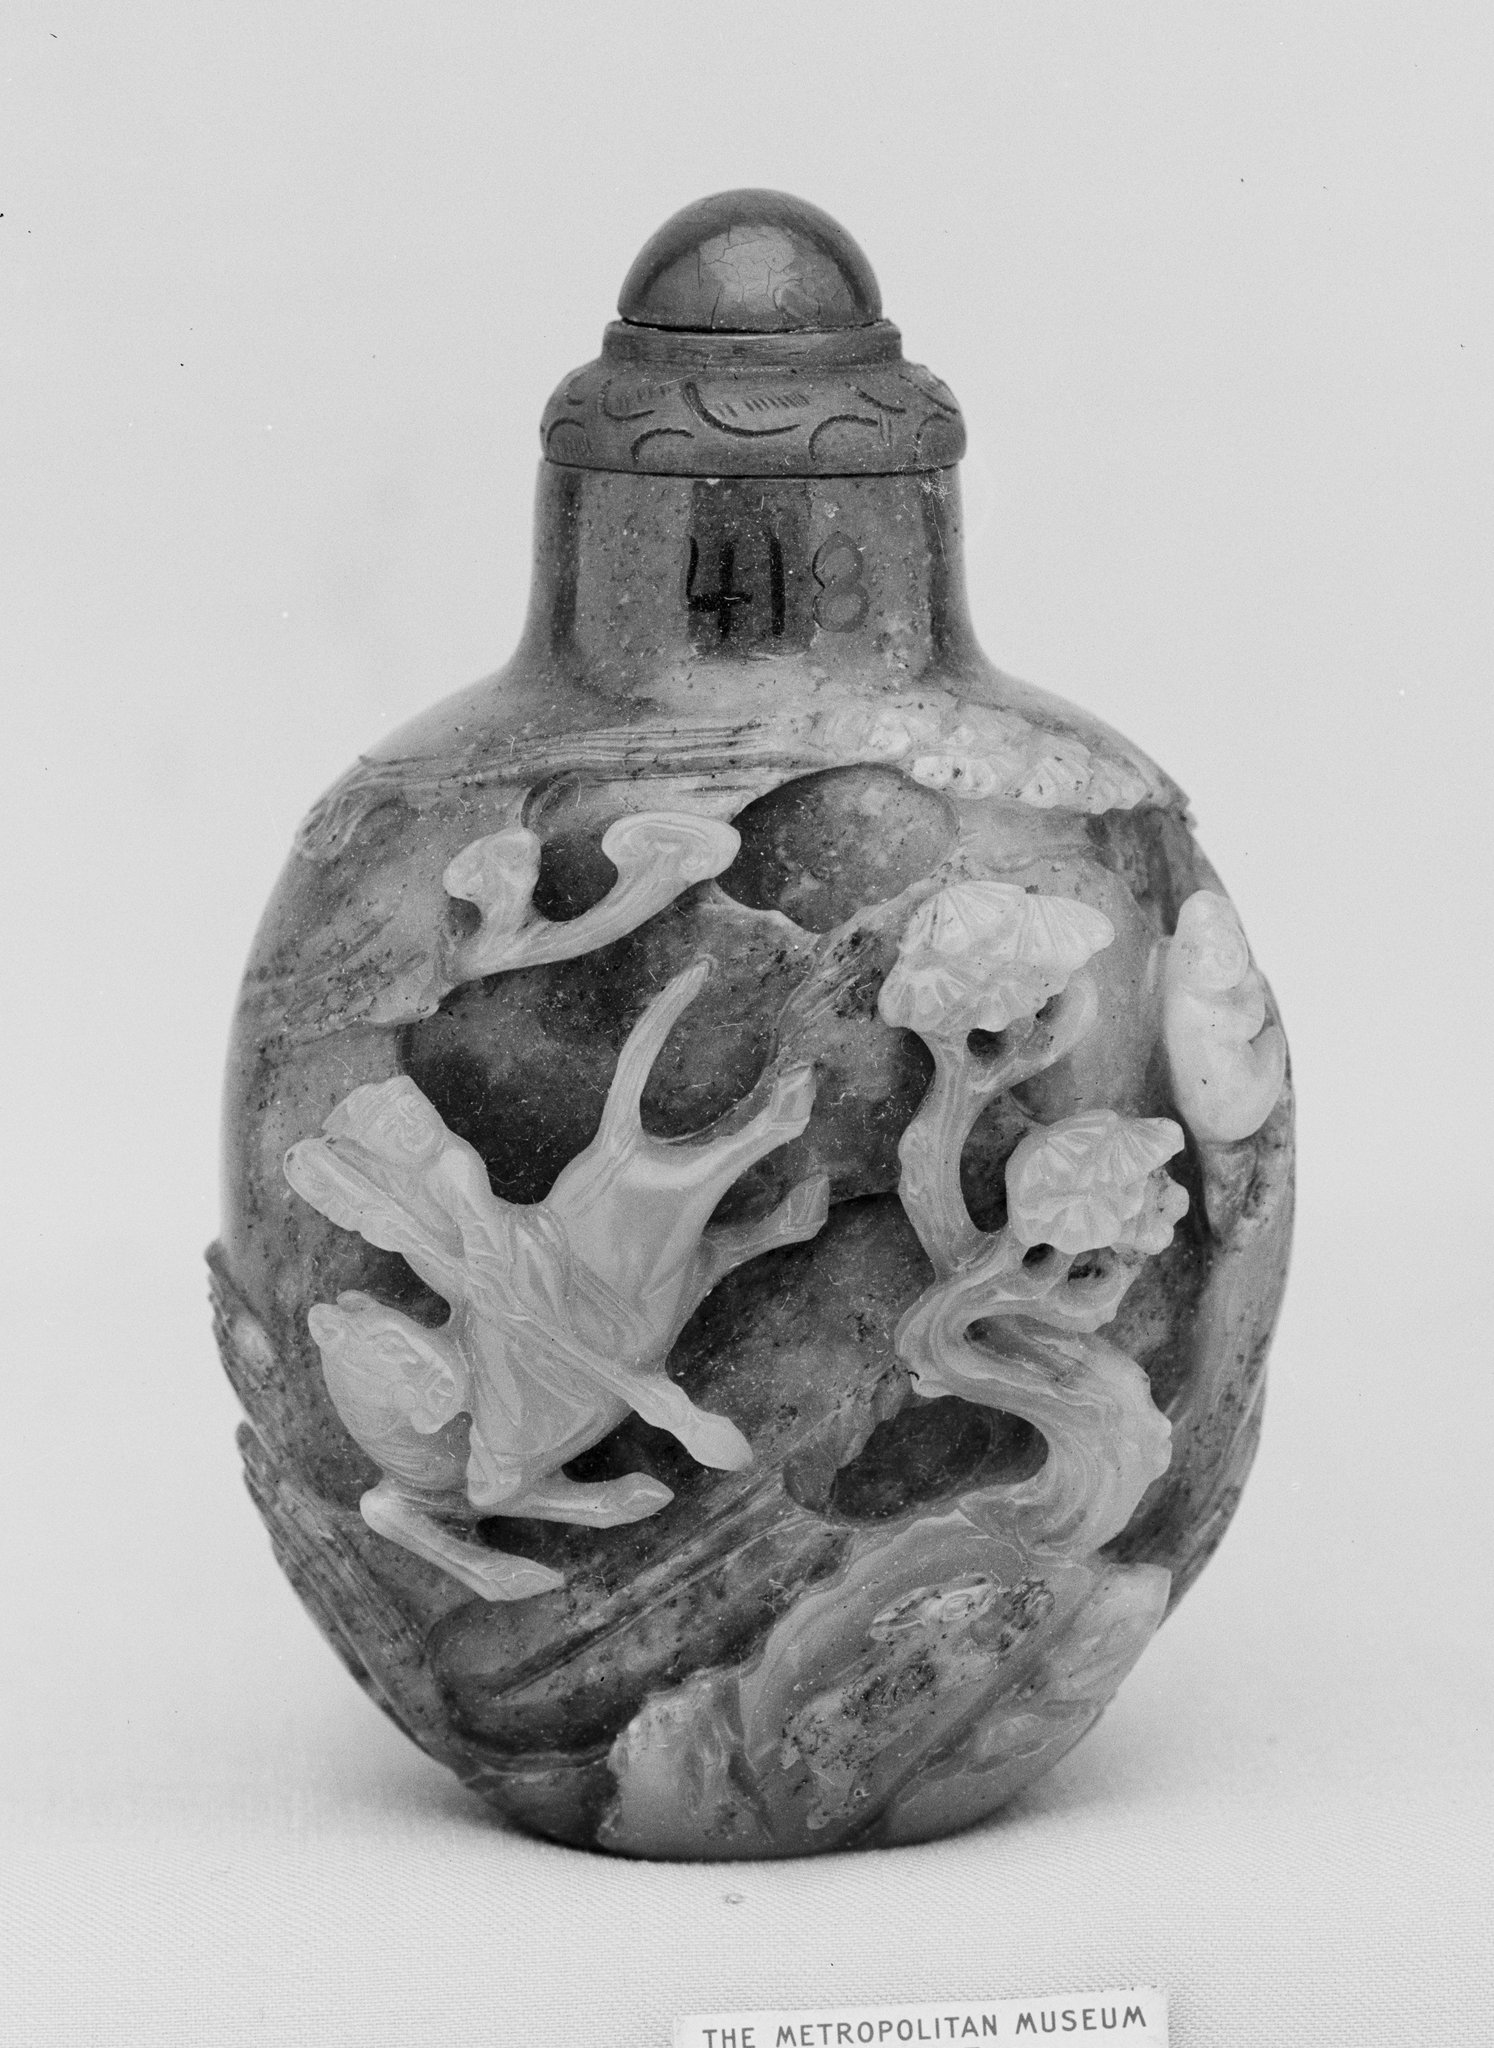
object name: snuff bottle with stopper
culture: chinese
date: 1644-1911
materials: jade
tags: horses